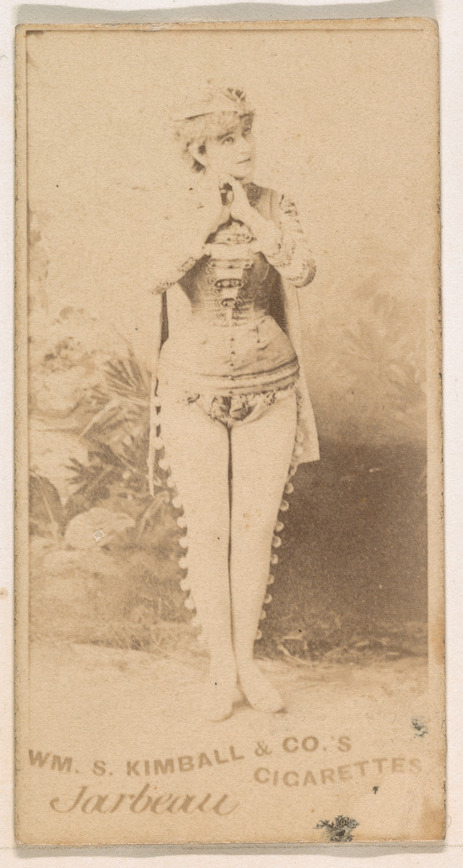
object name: photograph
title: Miss Jarbeau, from the Actresses series (N203) issued by Wm. S. Kimball & Co.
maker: william s. kimball & company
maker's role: publisher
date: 1889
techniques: color lithograph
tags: portraits,women,actresses